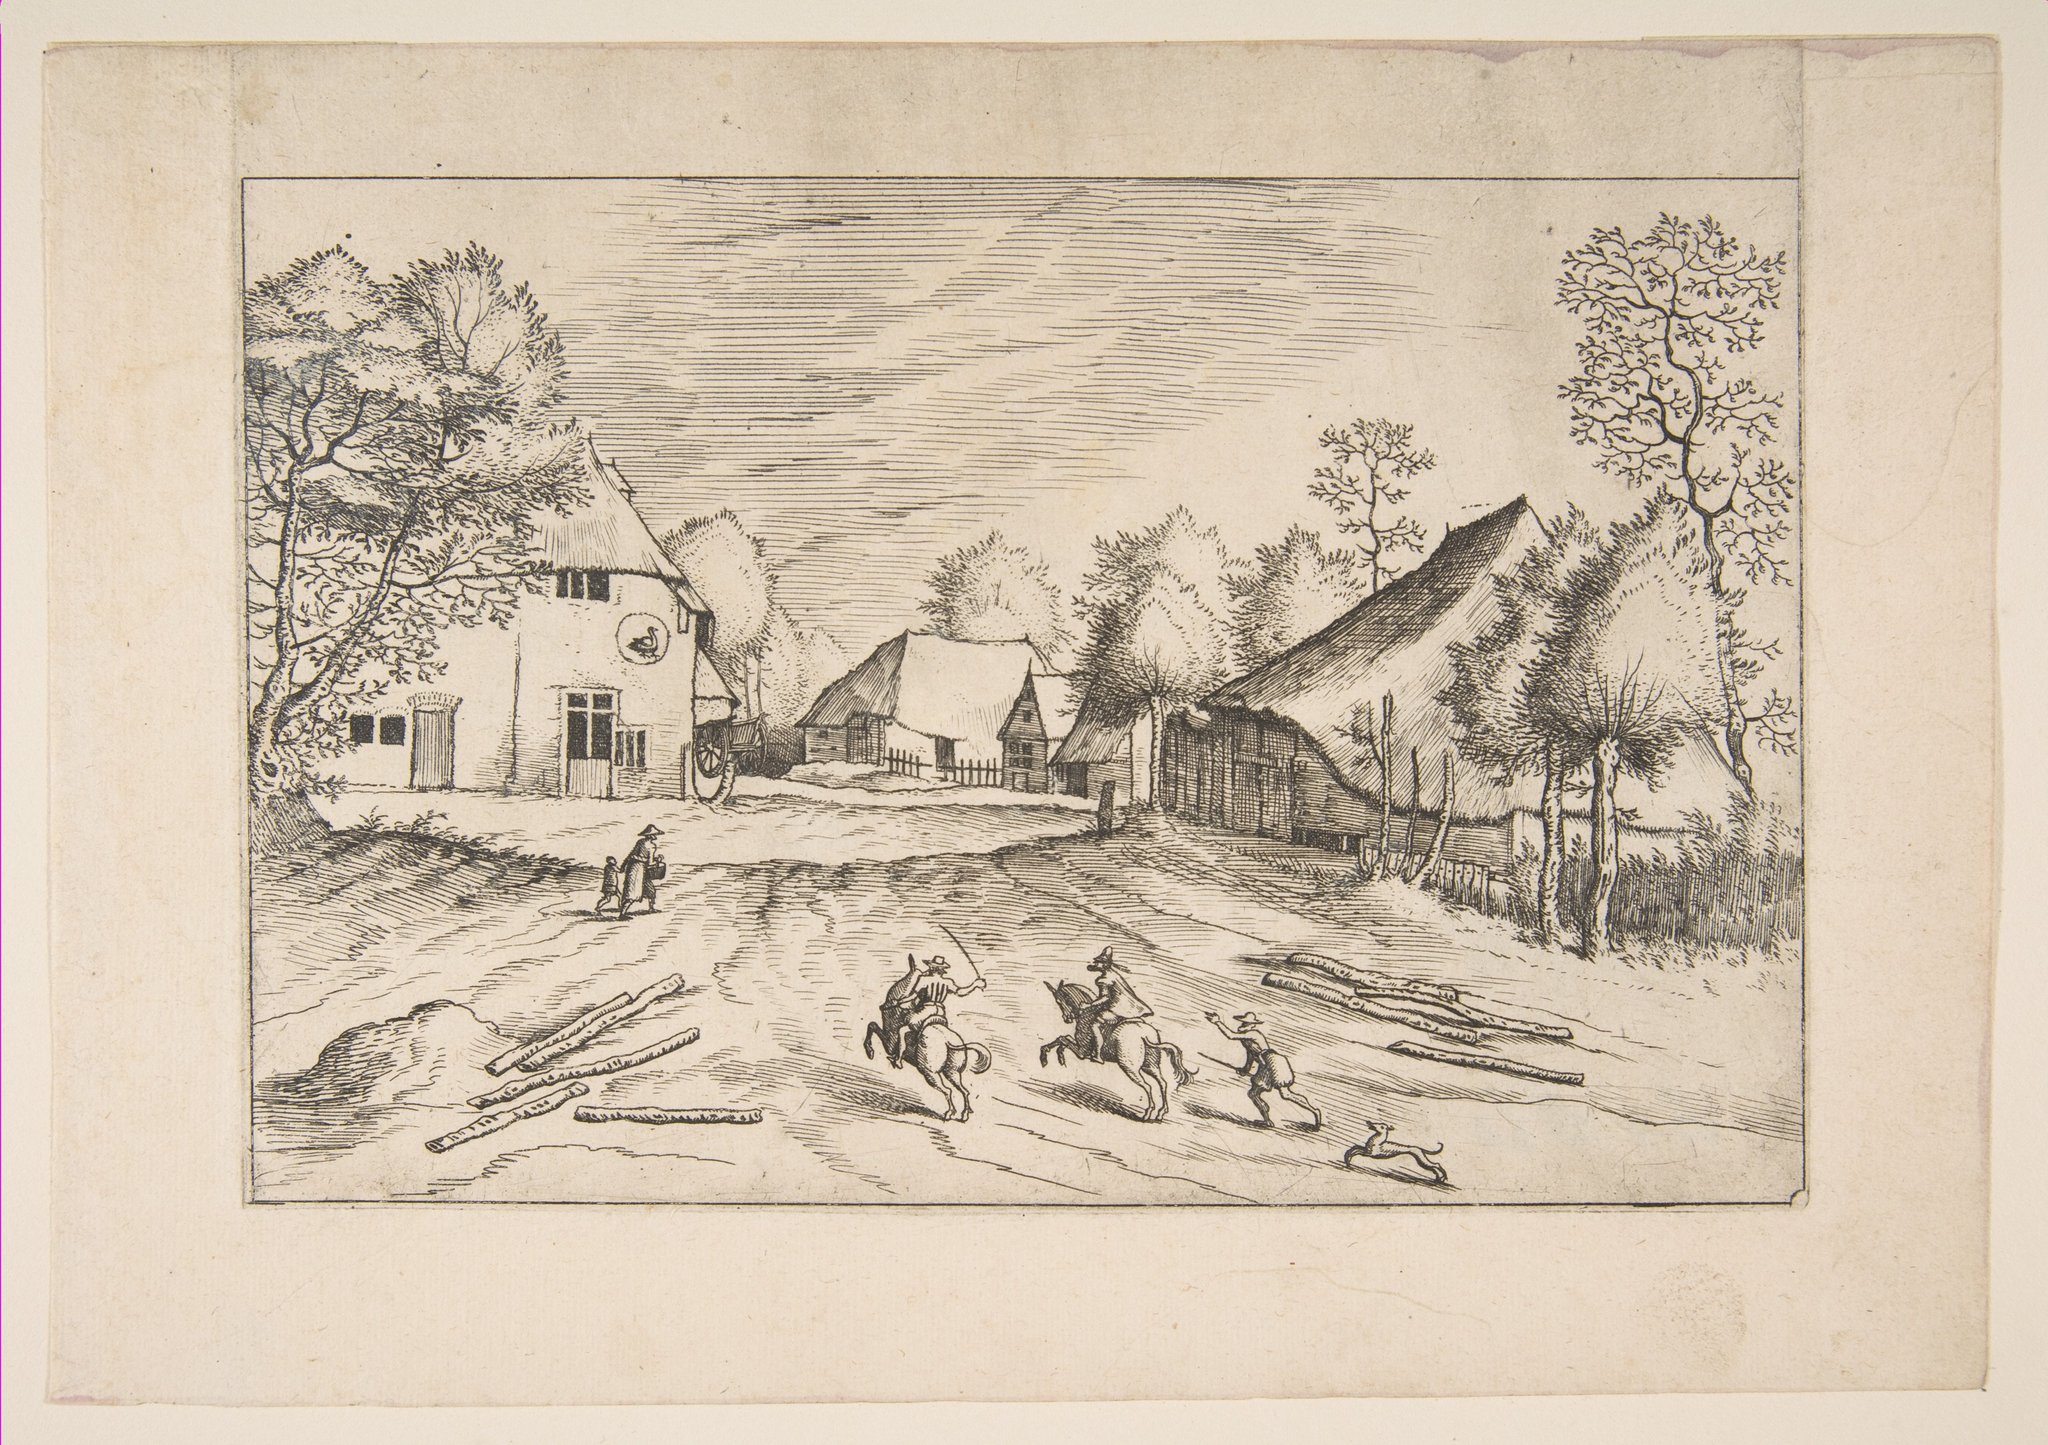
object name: print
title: The Swan's Inn with Farms from the series The Small Landscapes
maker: the master of the small landscapes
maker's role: artist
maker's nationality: netherlandish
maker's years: 1500-1600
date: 1559-1561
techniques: etching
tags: human figures,houses,horses,landscapes